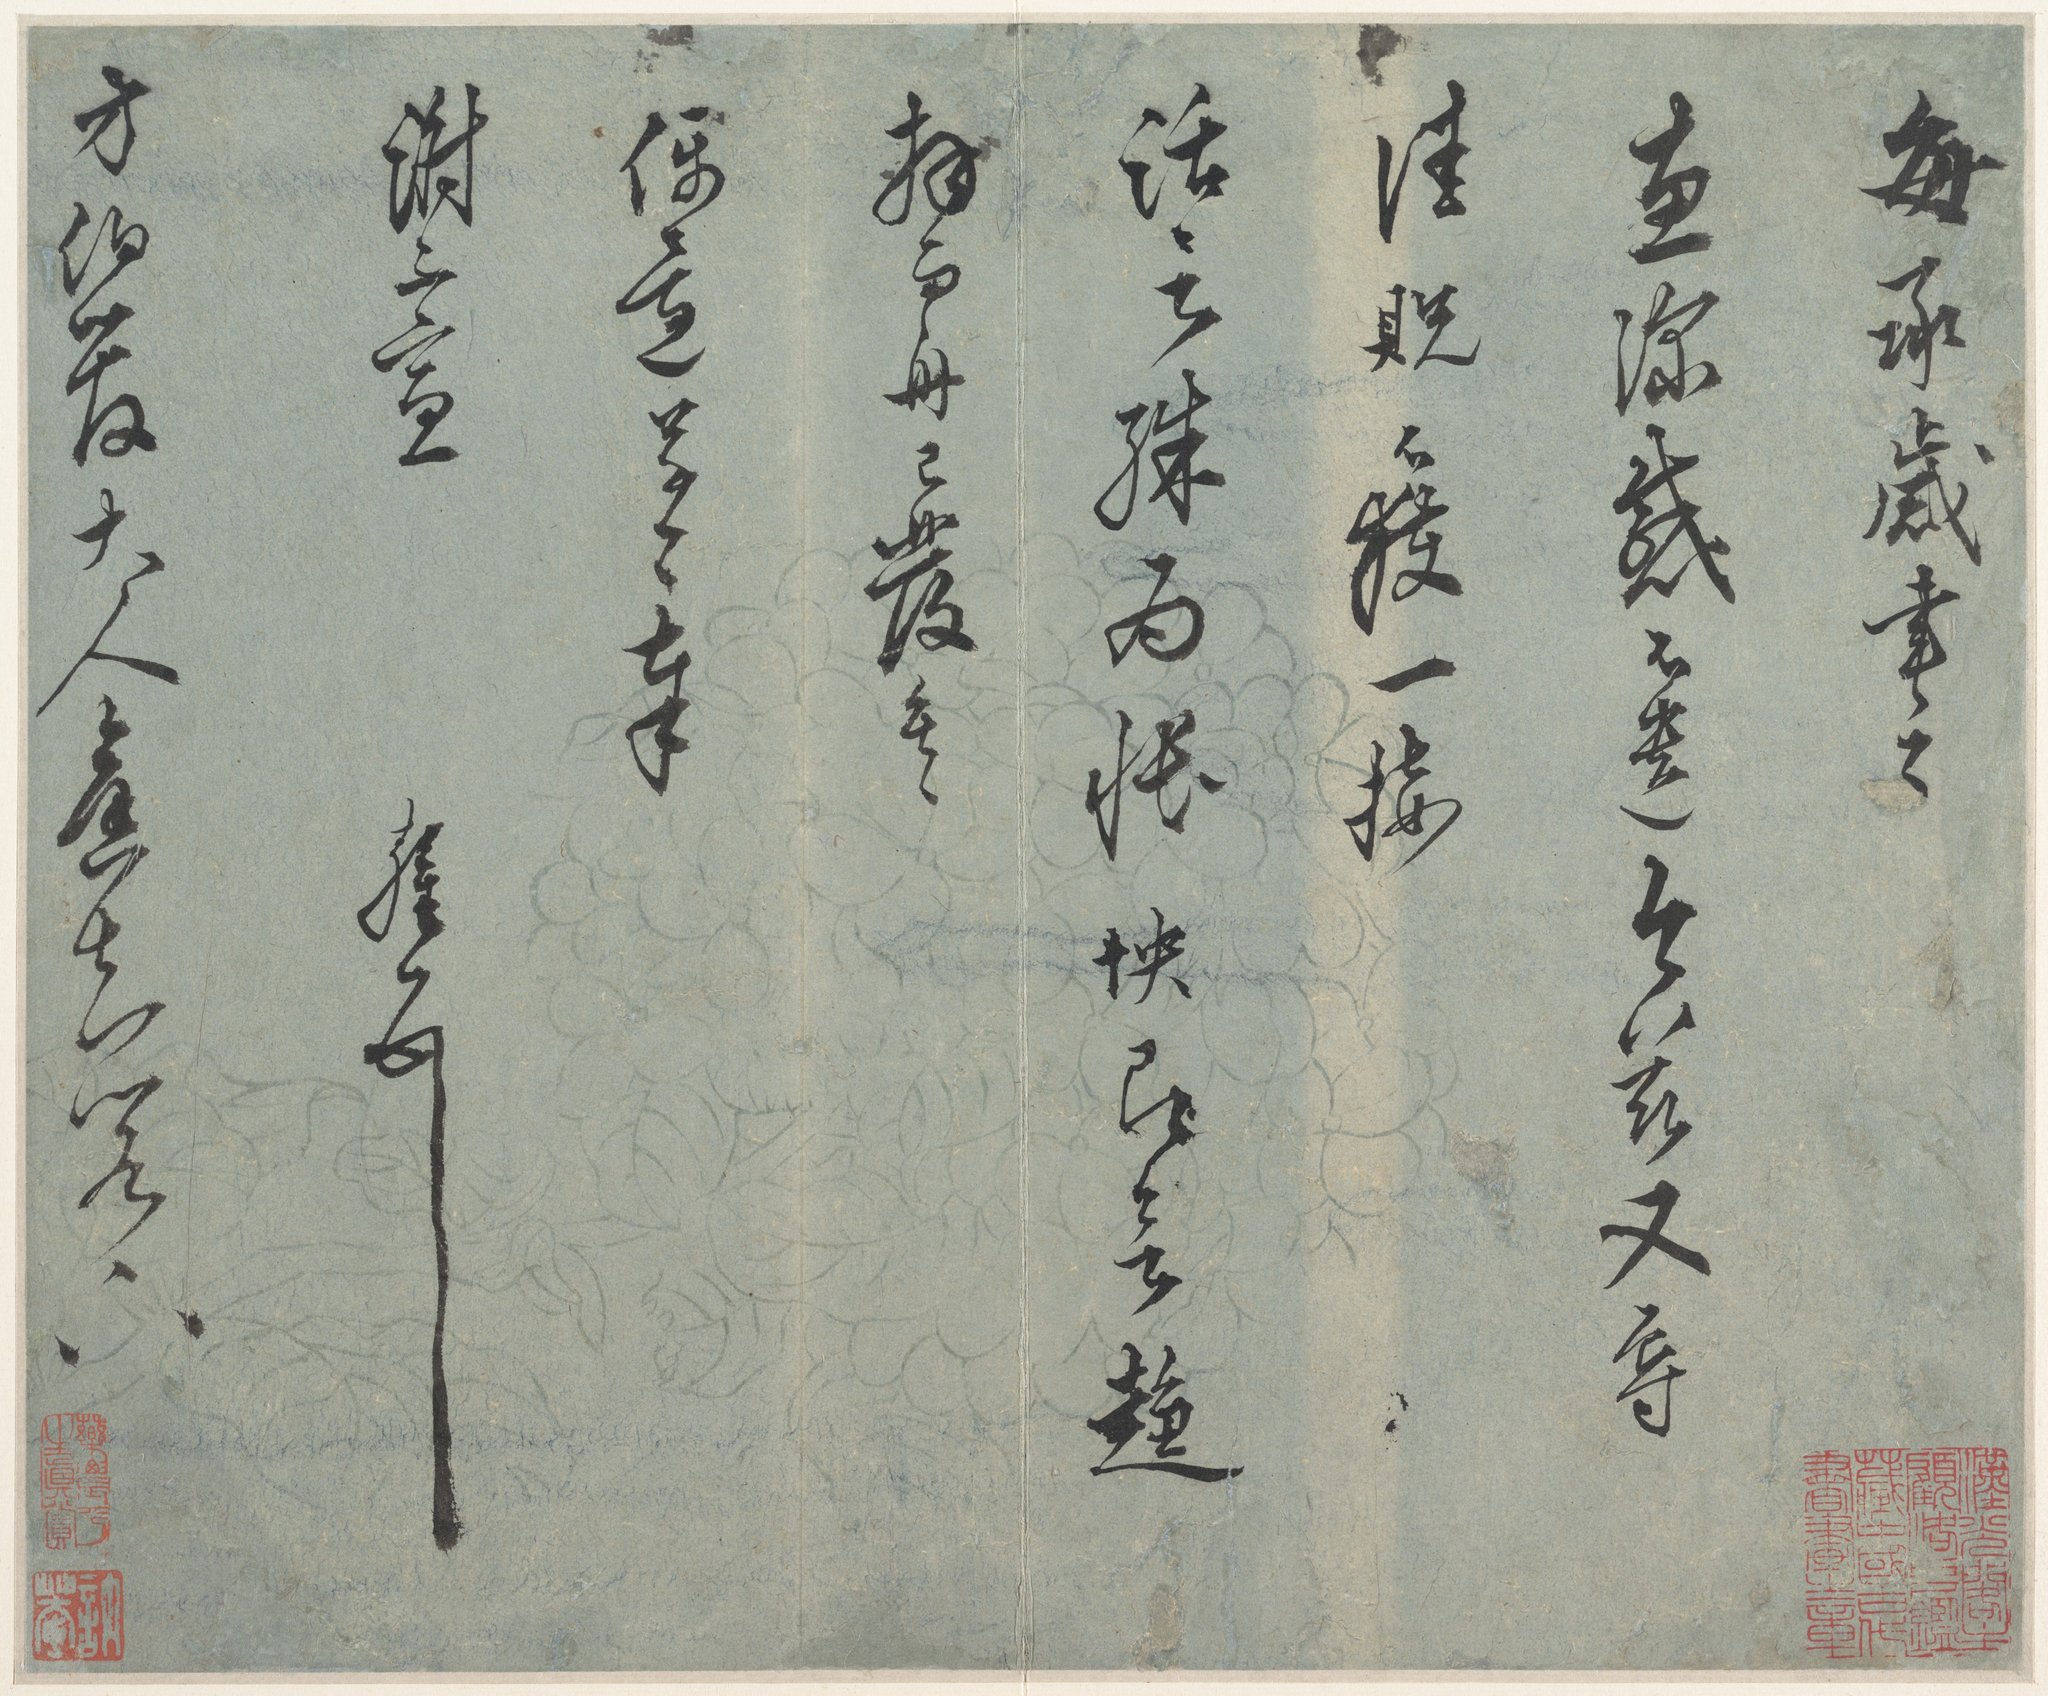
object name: album leaf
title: Letter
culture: chinese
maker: wang ao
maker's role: artist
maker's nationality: chinese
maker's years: 1450-1524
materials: ink, paper